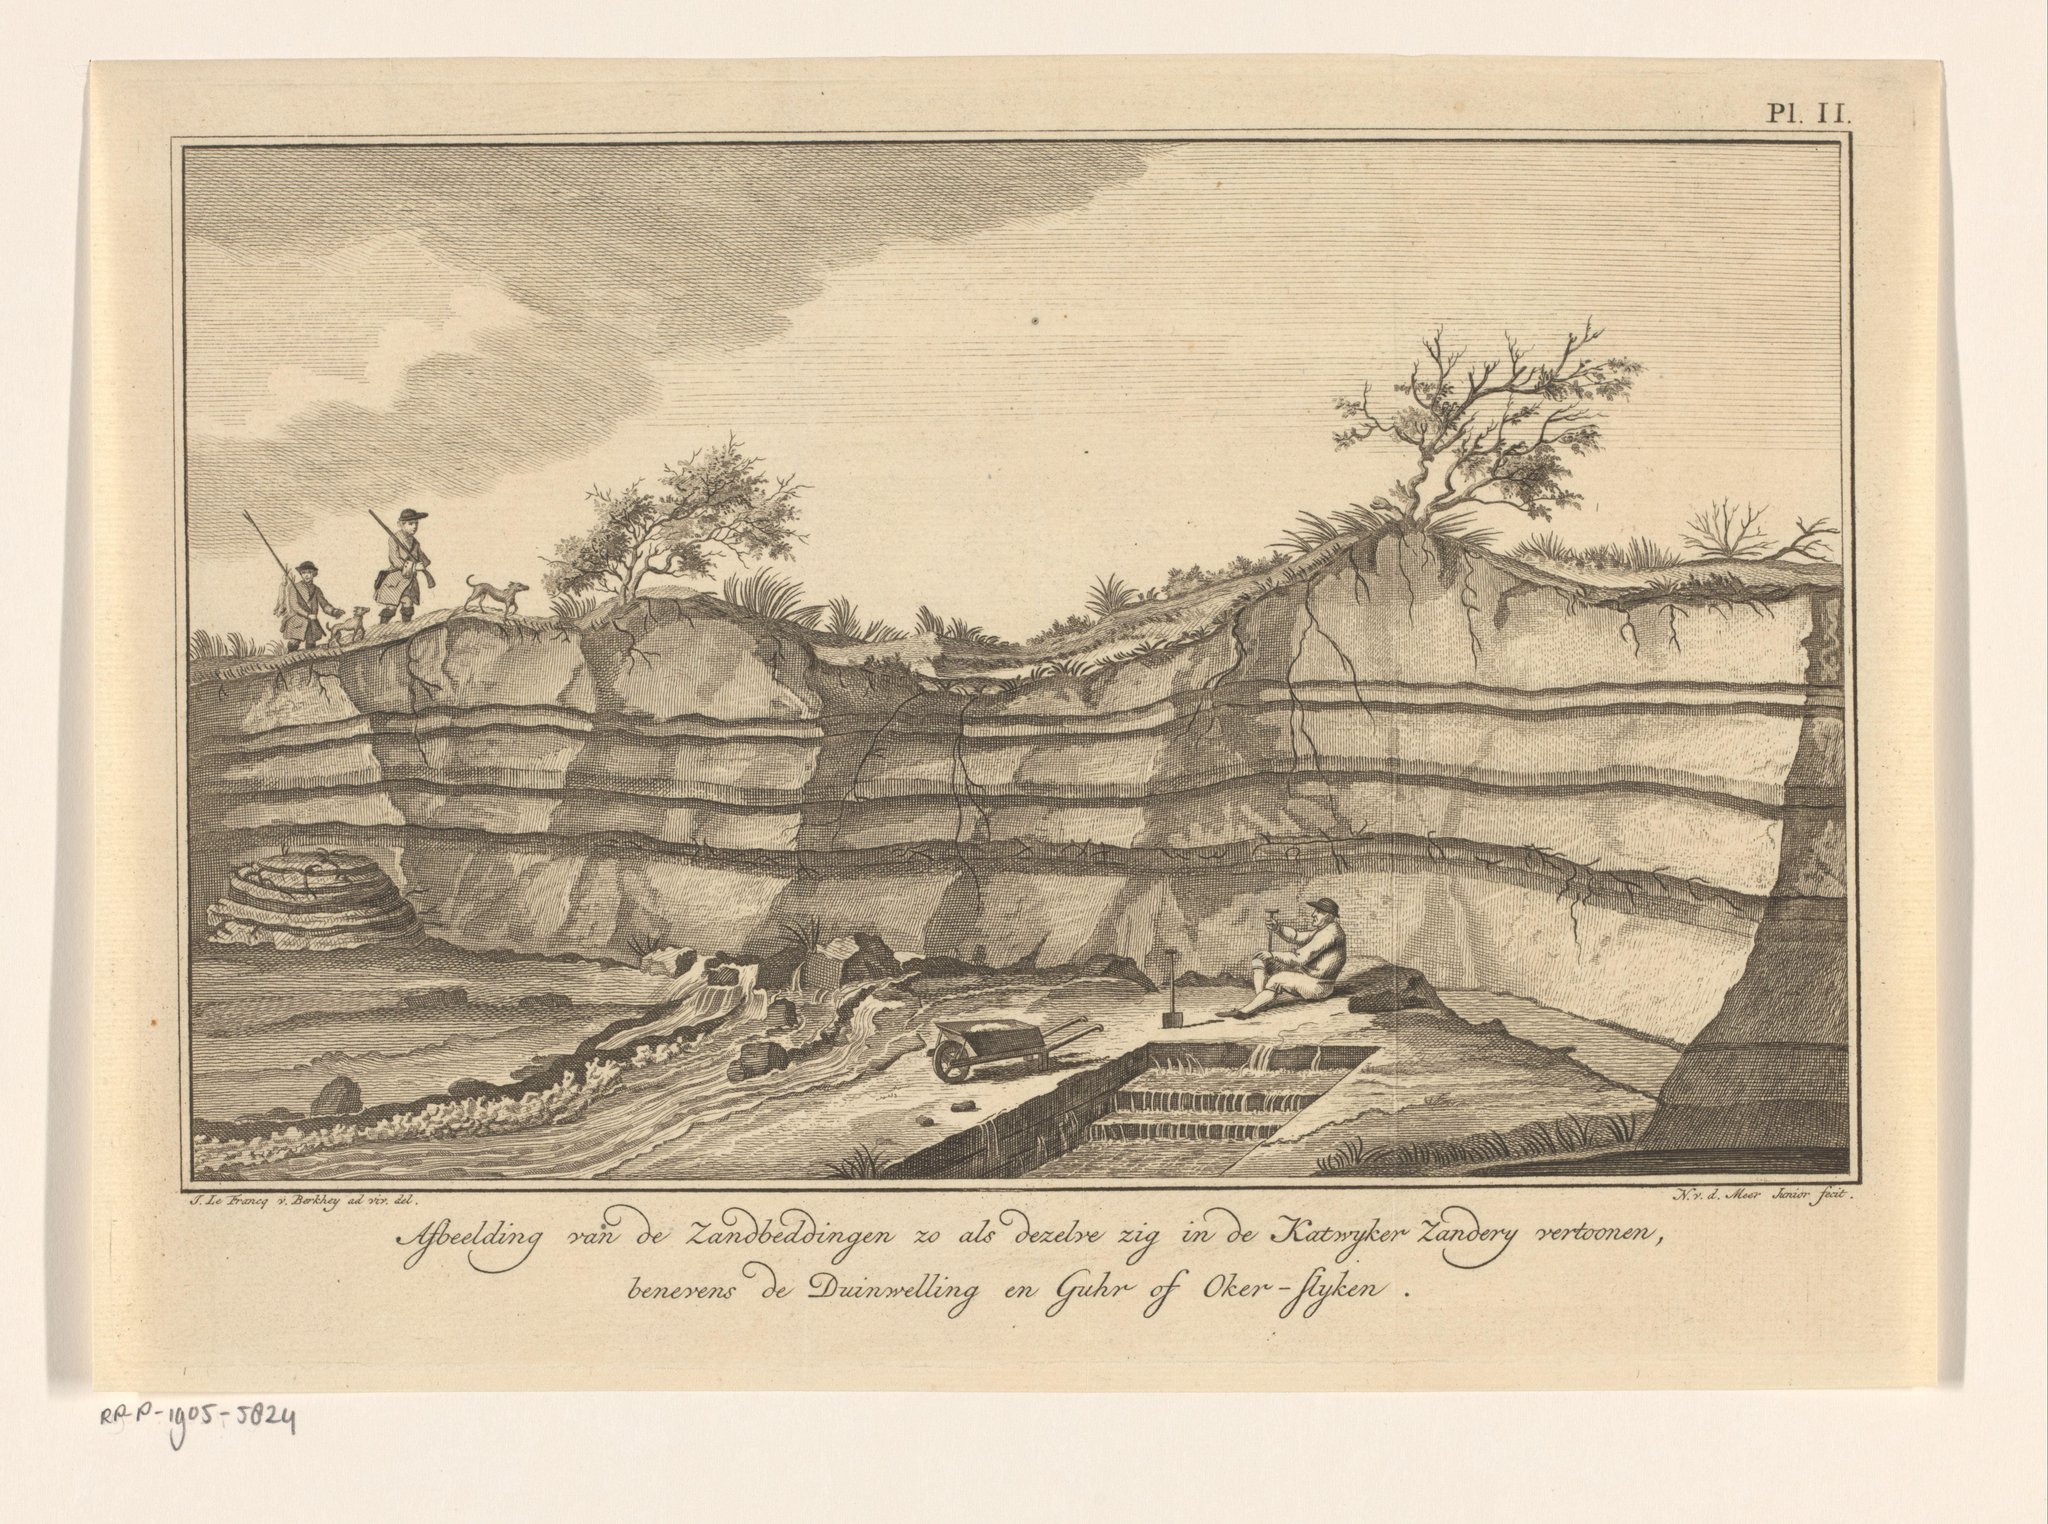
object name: book illustration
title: Zanderij bij Katwijk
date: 1769-1779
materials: paper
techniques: etching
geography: amsterdam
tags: sand (soil type), excavation ~ archaeology (+ variant), hunter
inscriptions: collector's mark: Lugt 2228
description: De zandafgraving bij Katwijk. Op de grond zit een man met een schop. Boven de afgraving lopen twee jagers met jachthonden. Rechtsboven: Pl. II.